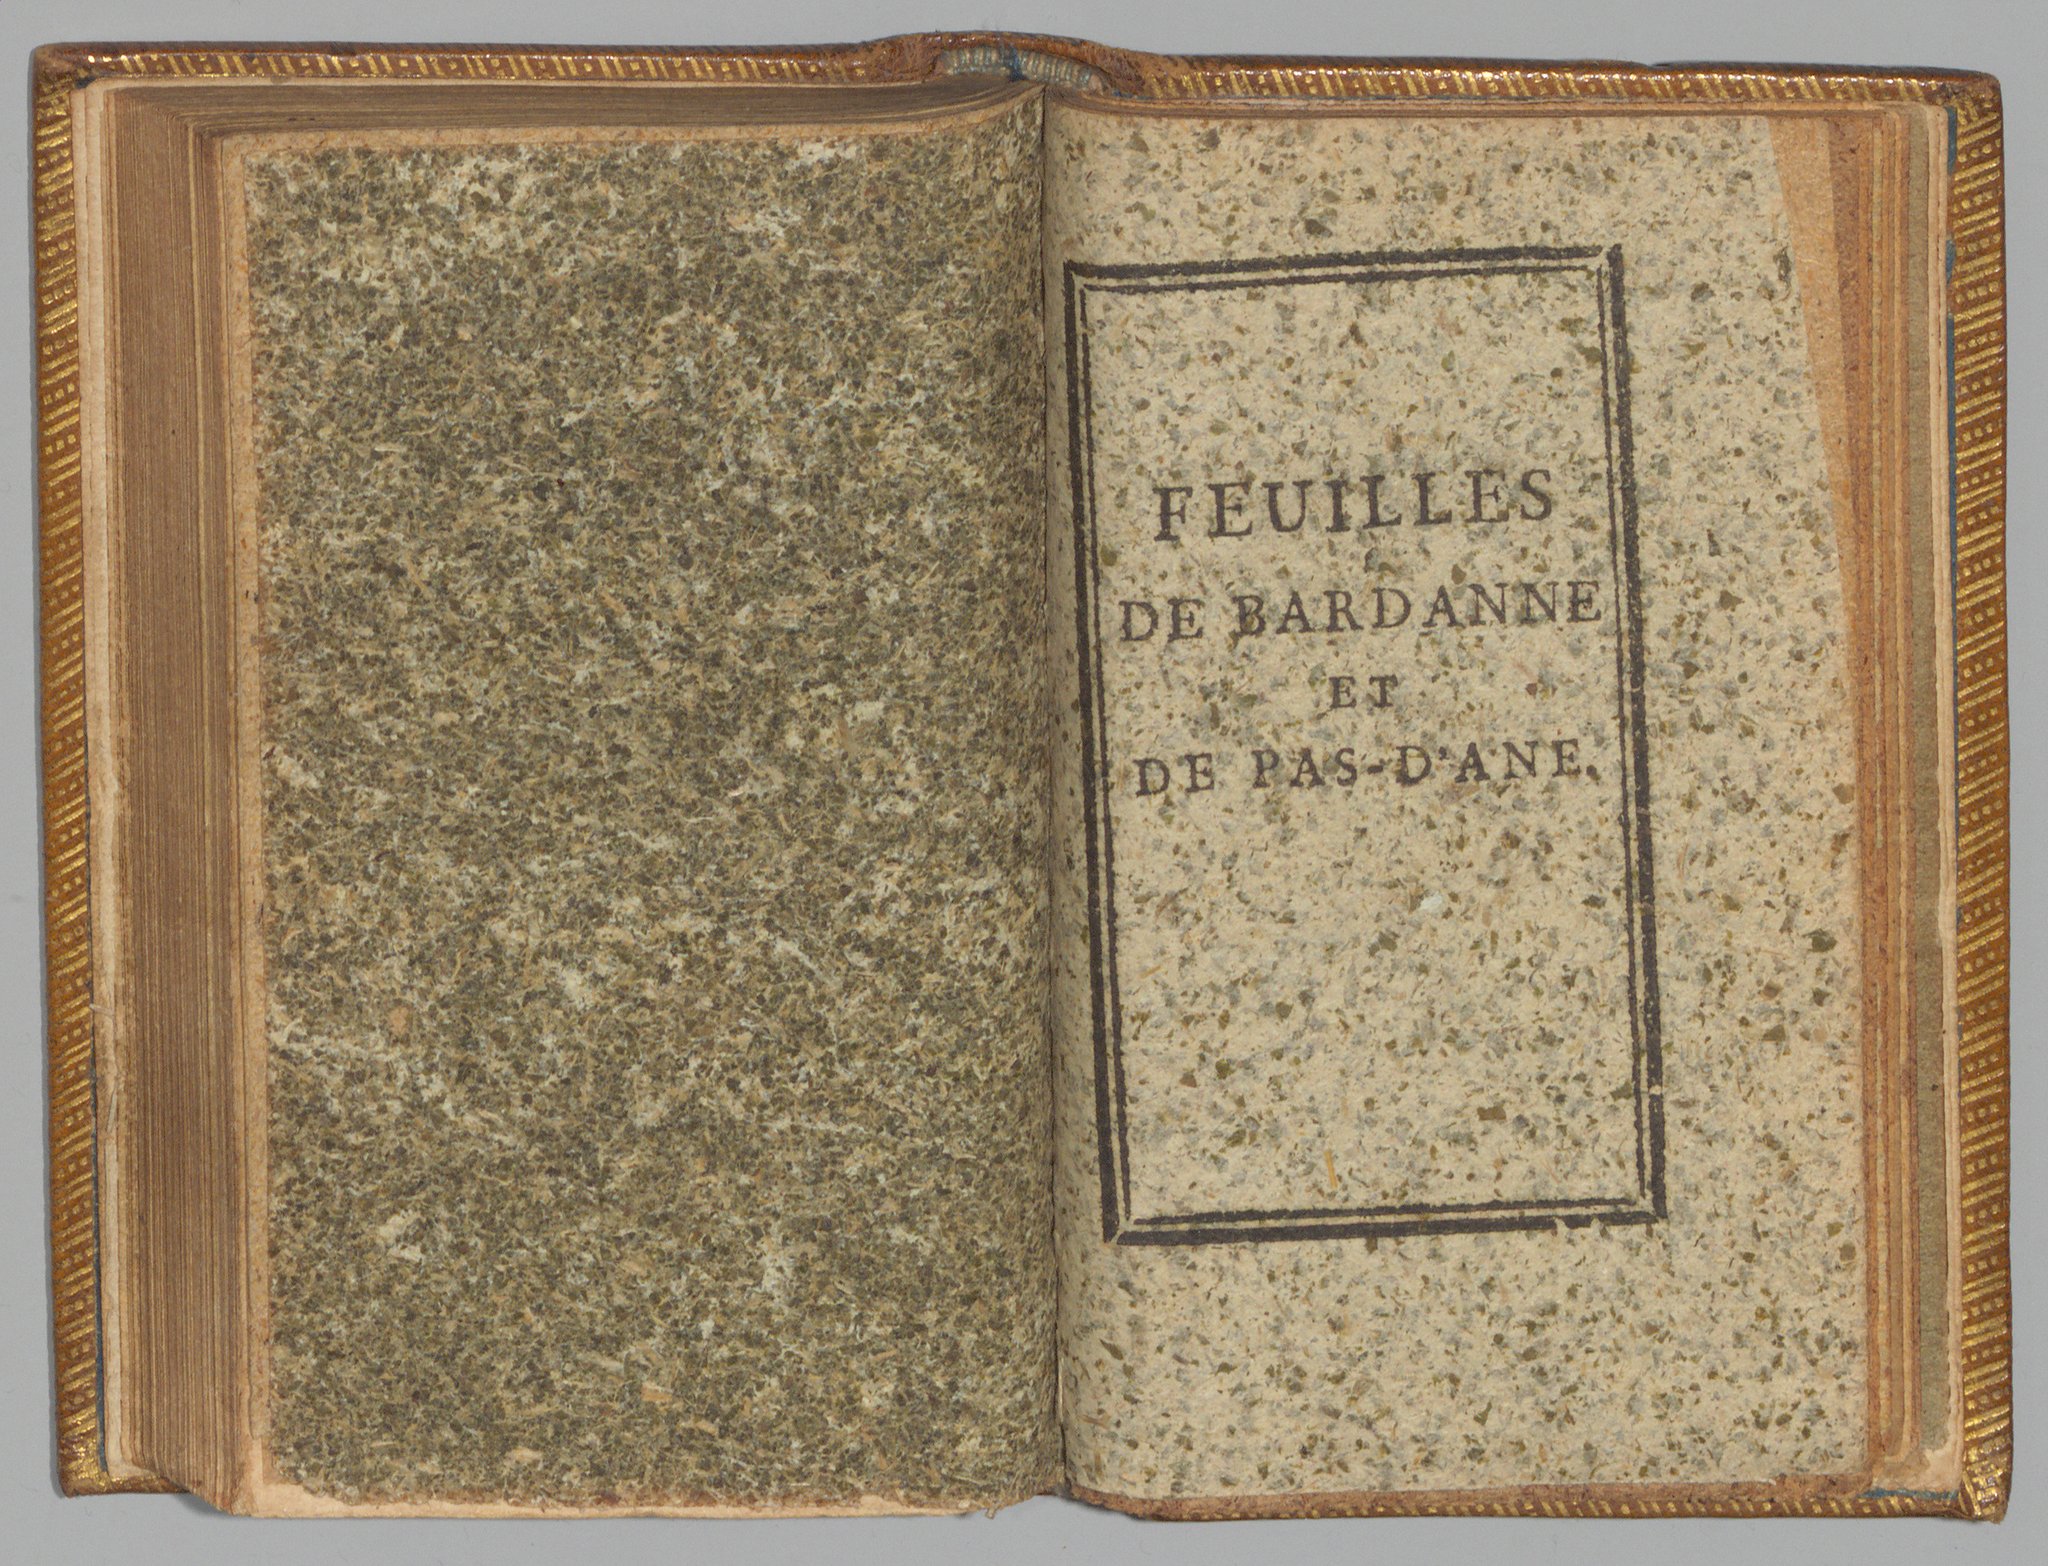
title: Œuvres du marquis de Villette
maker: charles-michel villette, marquis de villette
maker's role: author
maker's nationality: french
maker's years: 1736-1793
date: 1786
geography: france